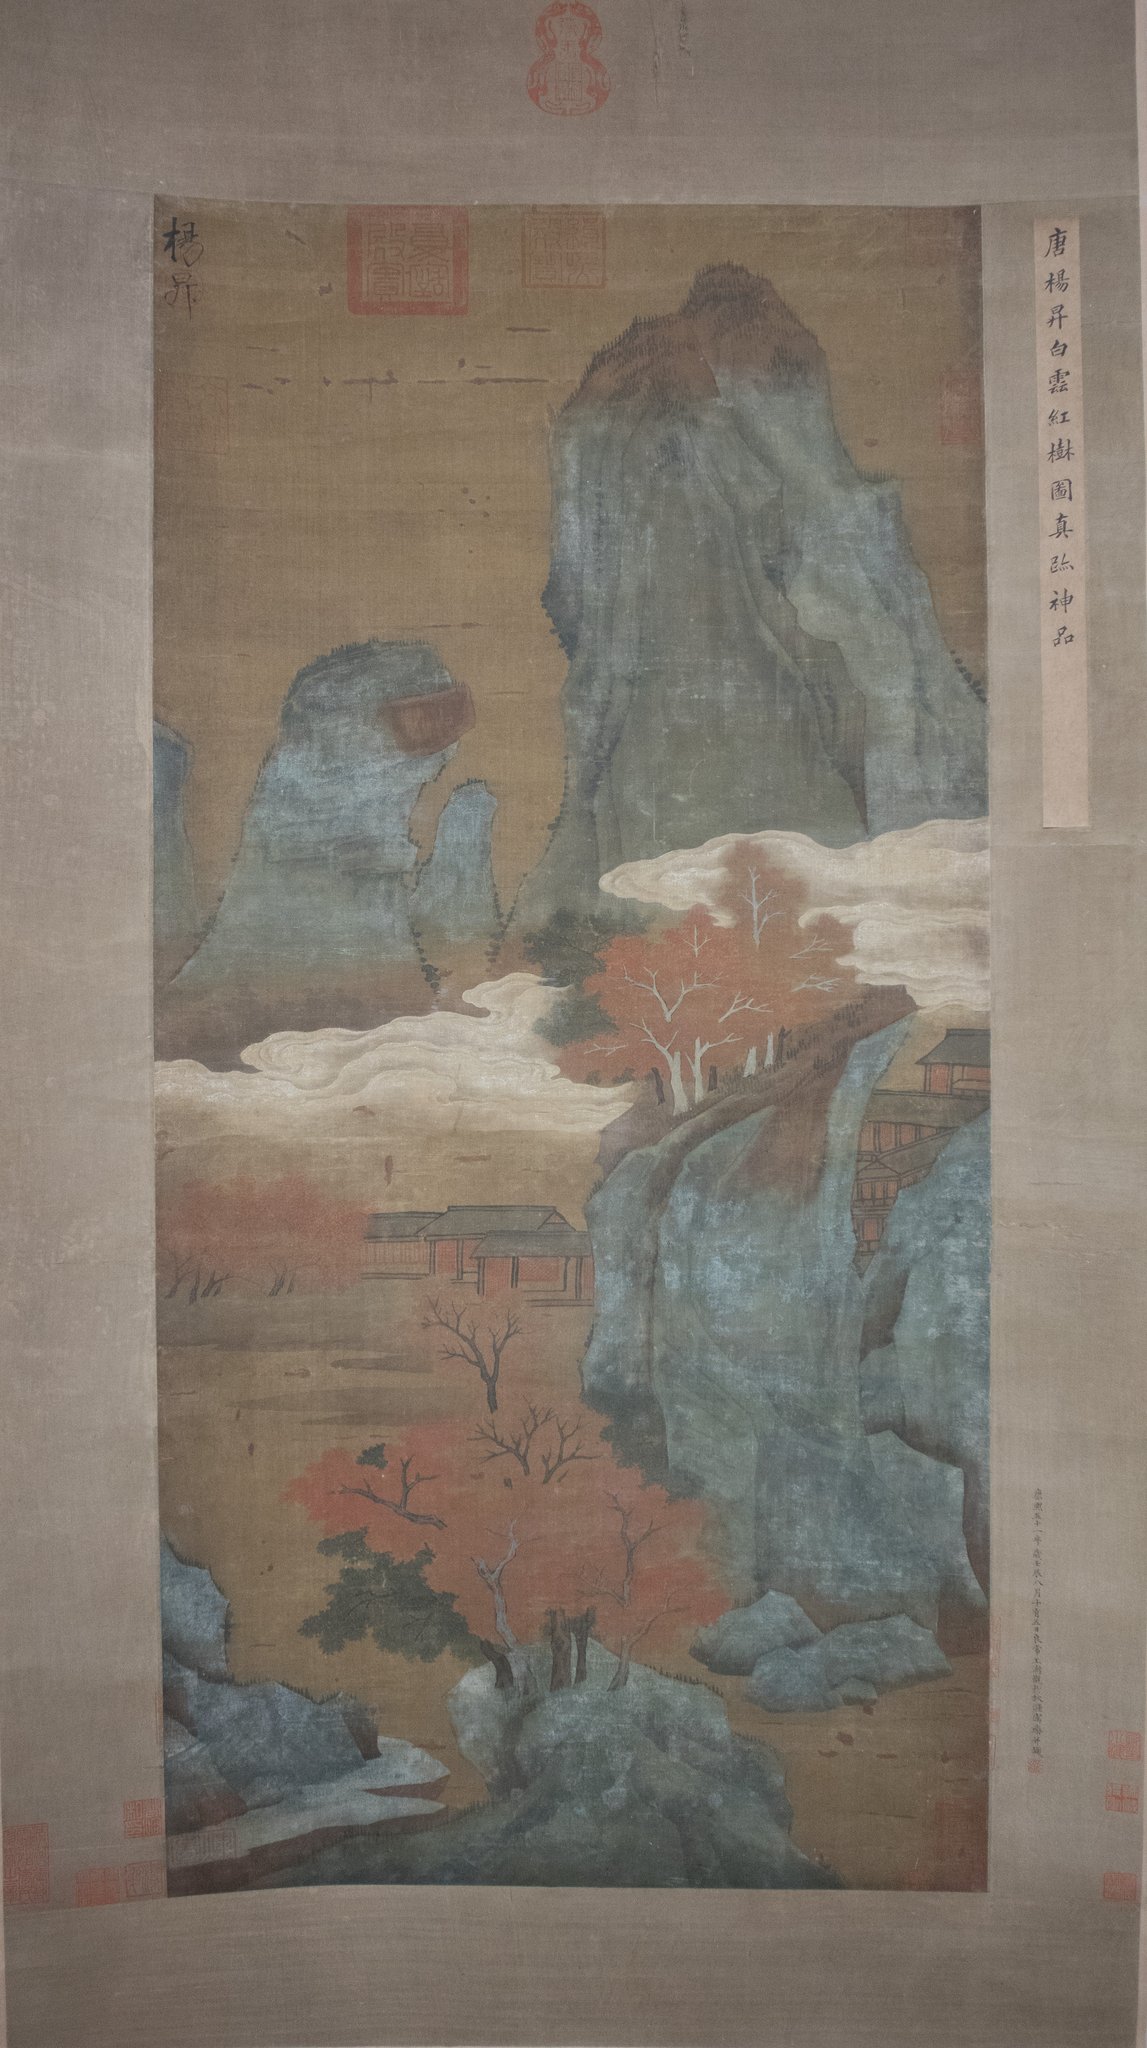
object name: hanging scroll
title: Misty Landscape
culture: chinese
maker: unidentified artist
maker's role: artist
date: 1368-1644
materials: ink, silk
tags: landscapes